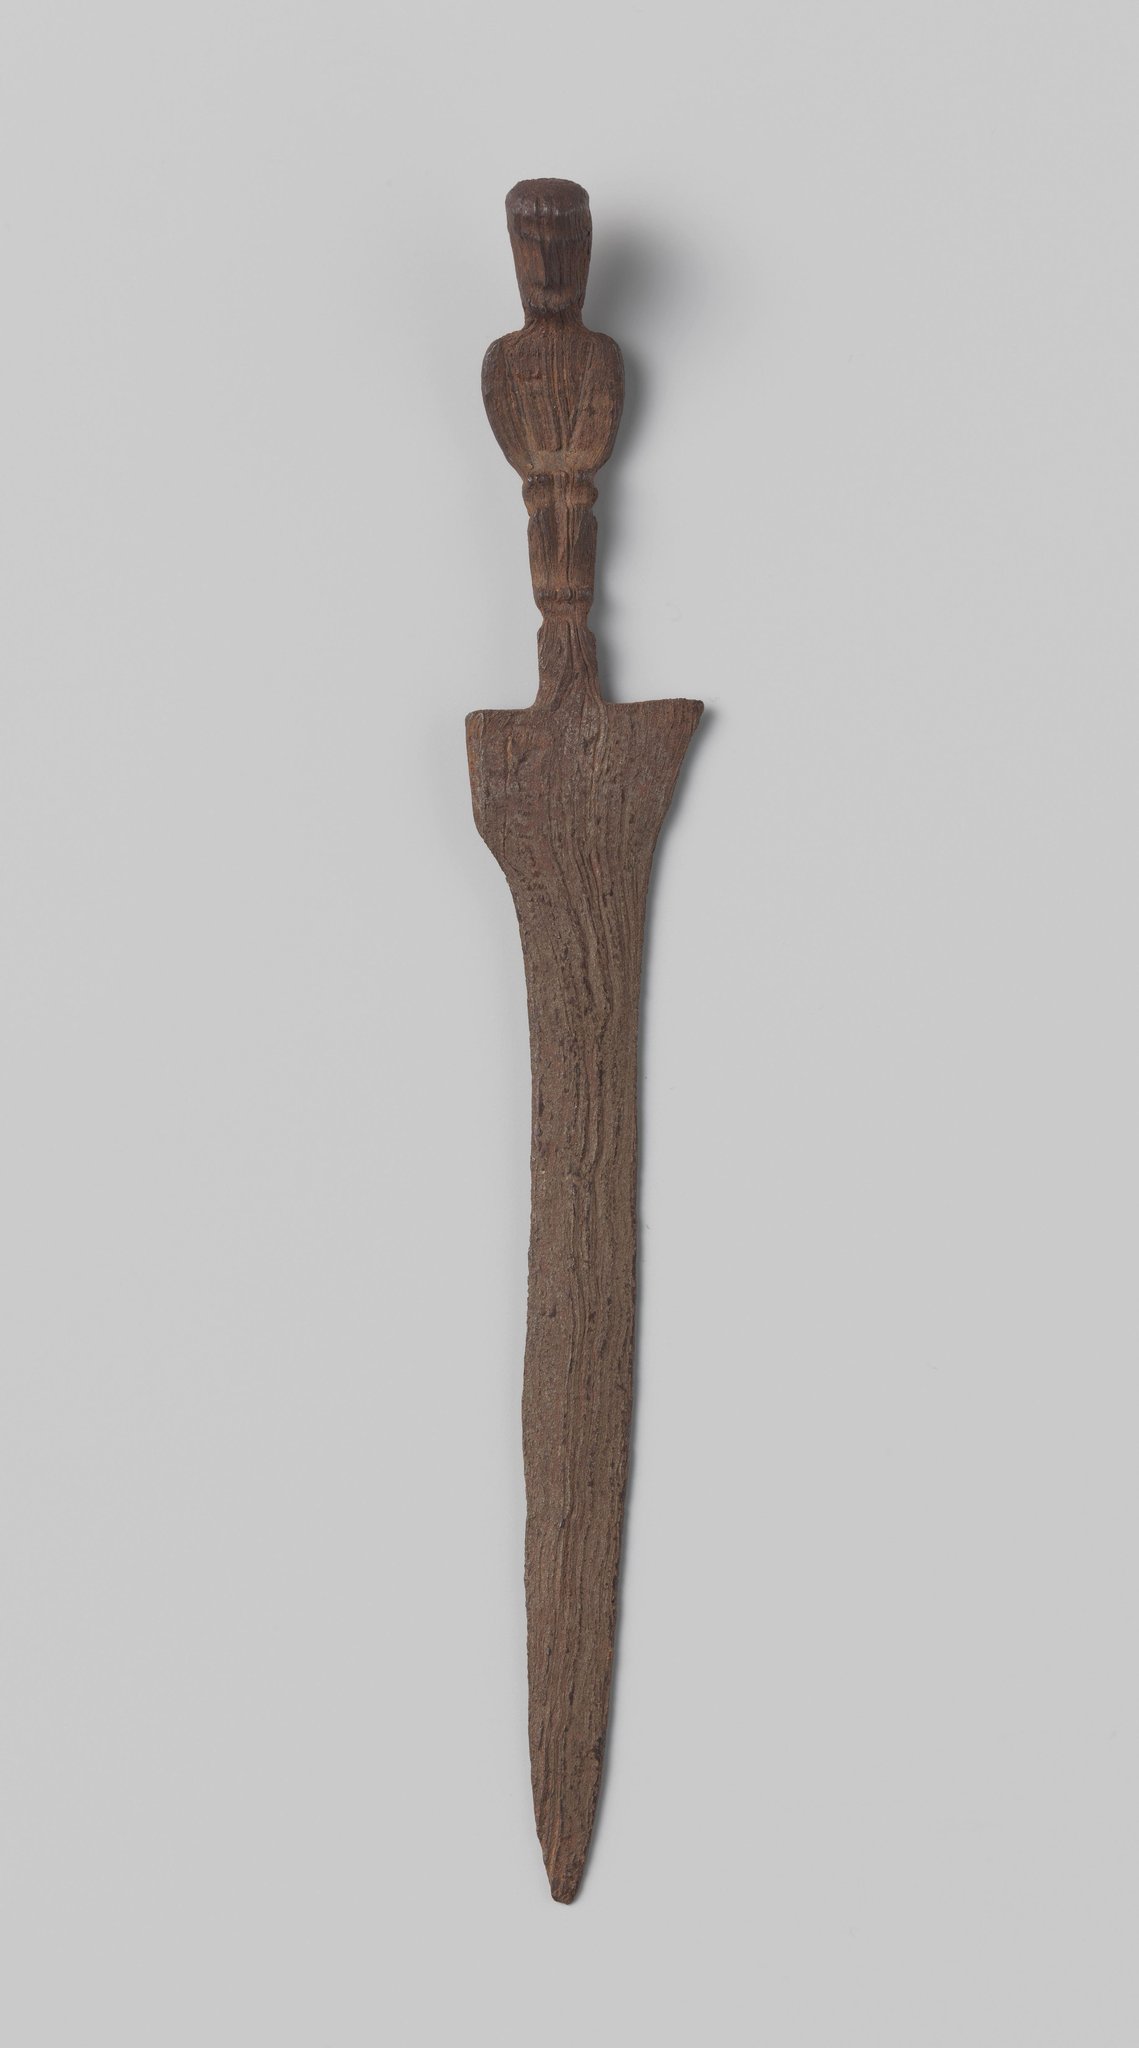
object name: kris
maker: Anonymous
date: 1300-1600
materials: iron, nickel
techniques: pamo technique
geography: java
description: Rituals can also be performed during non-religious occasions. This small kris was probably used in rites for the magic healing of wounds and disease.